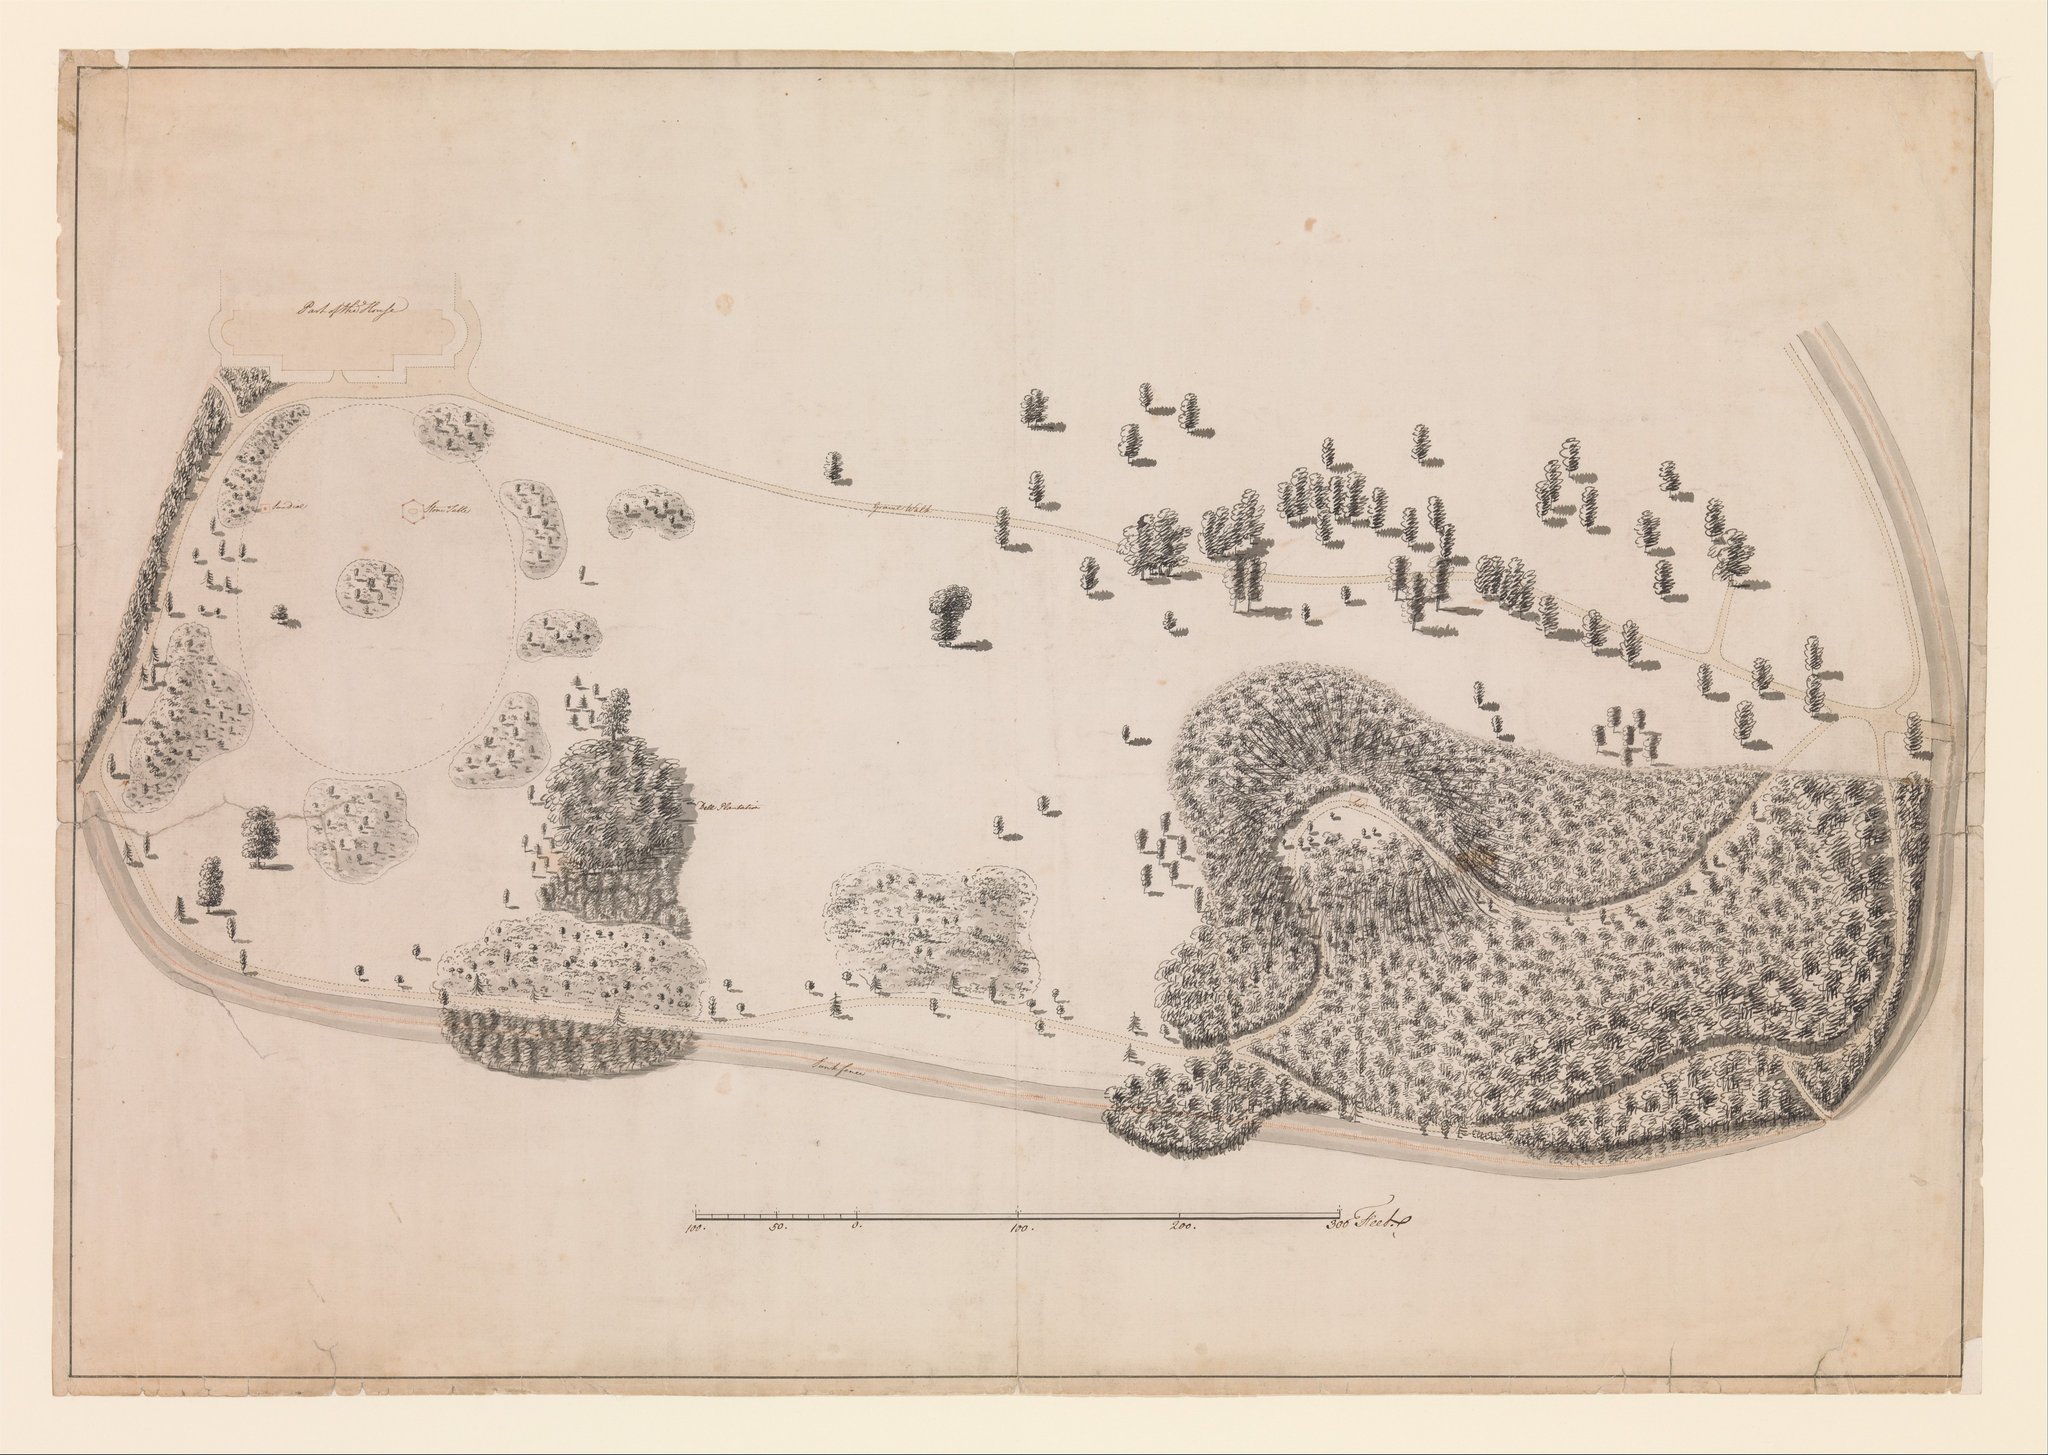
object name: drawing ornament and design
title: Luton Park, Bedfordshire, Plan for Planting South-East of the House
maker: lancelot "capability" brown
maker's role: artist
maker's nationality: british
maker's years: 1716-1783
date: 1764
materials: ink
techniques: brush, pen, wash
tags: parks